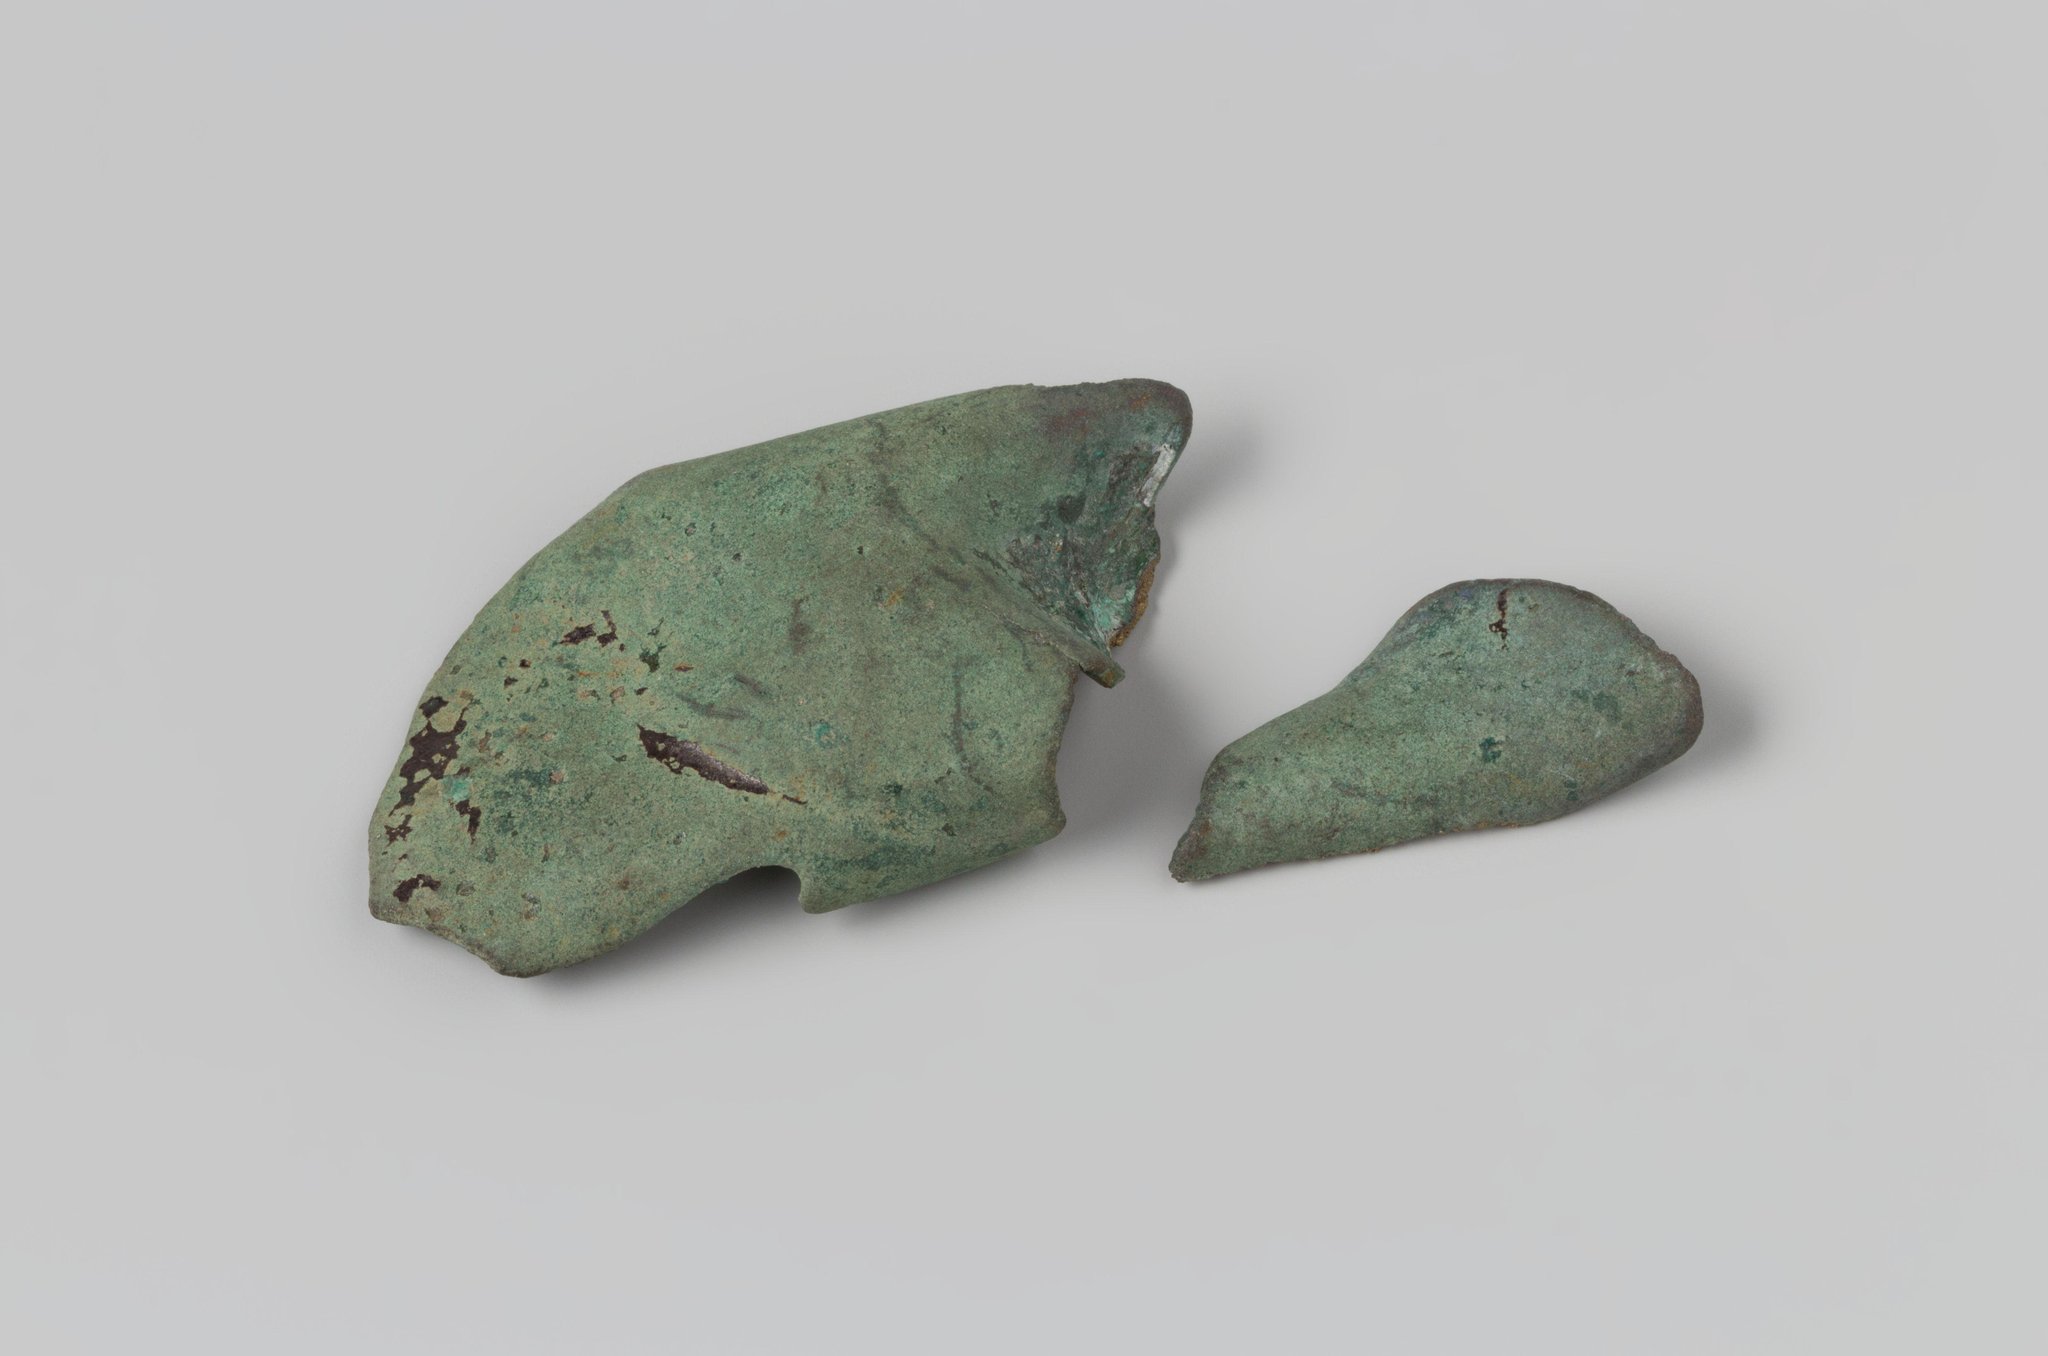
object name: scheepswrakvondst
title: Fragment van koper uit het wrak van de Oost-Indiëvaarder Hollandia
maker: Anonymous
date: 1700-1743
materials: copper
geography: netherlands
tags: verenigde oostindische compagnie, hollandia (schip), annet